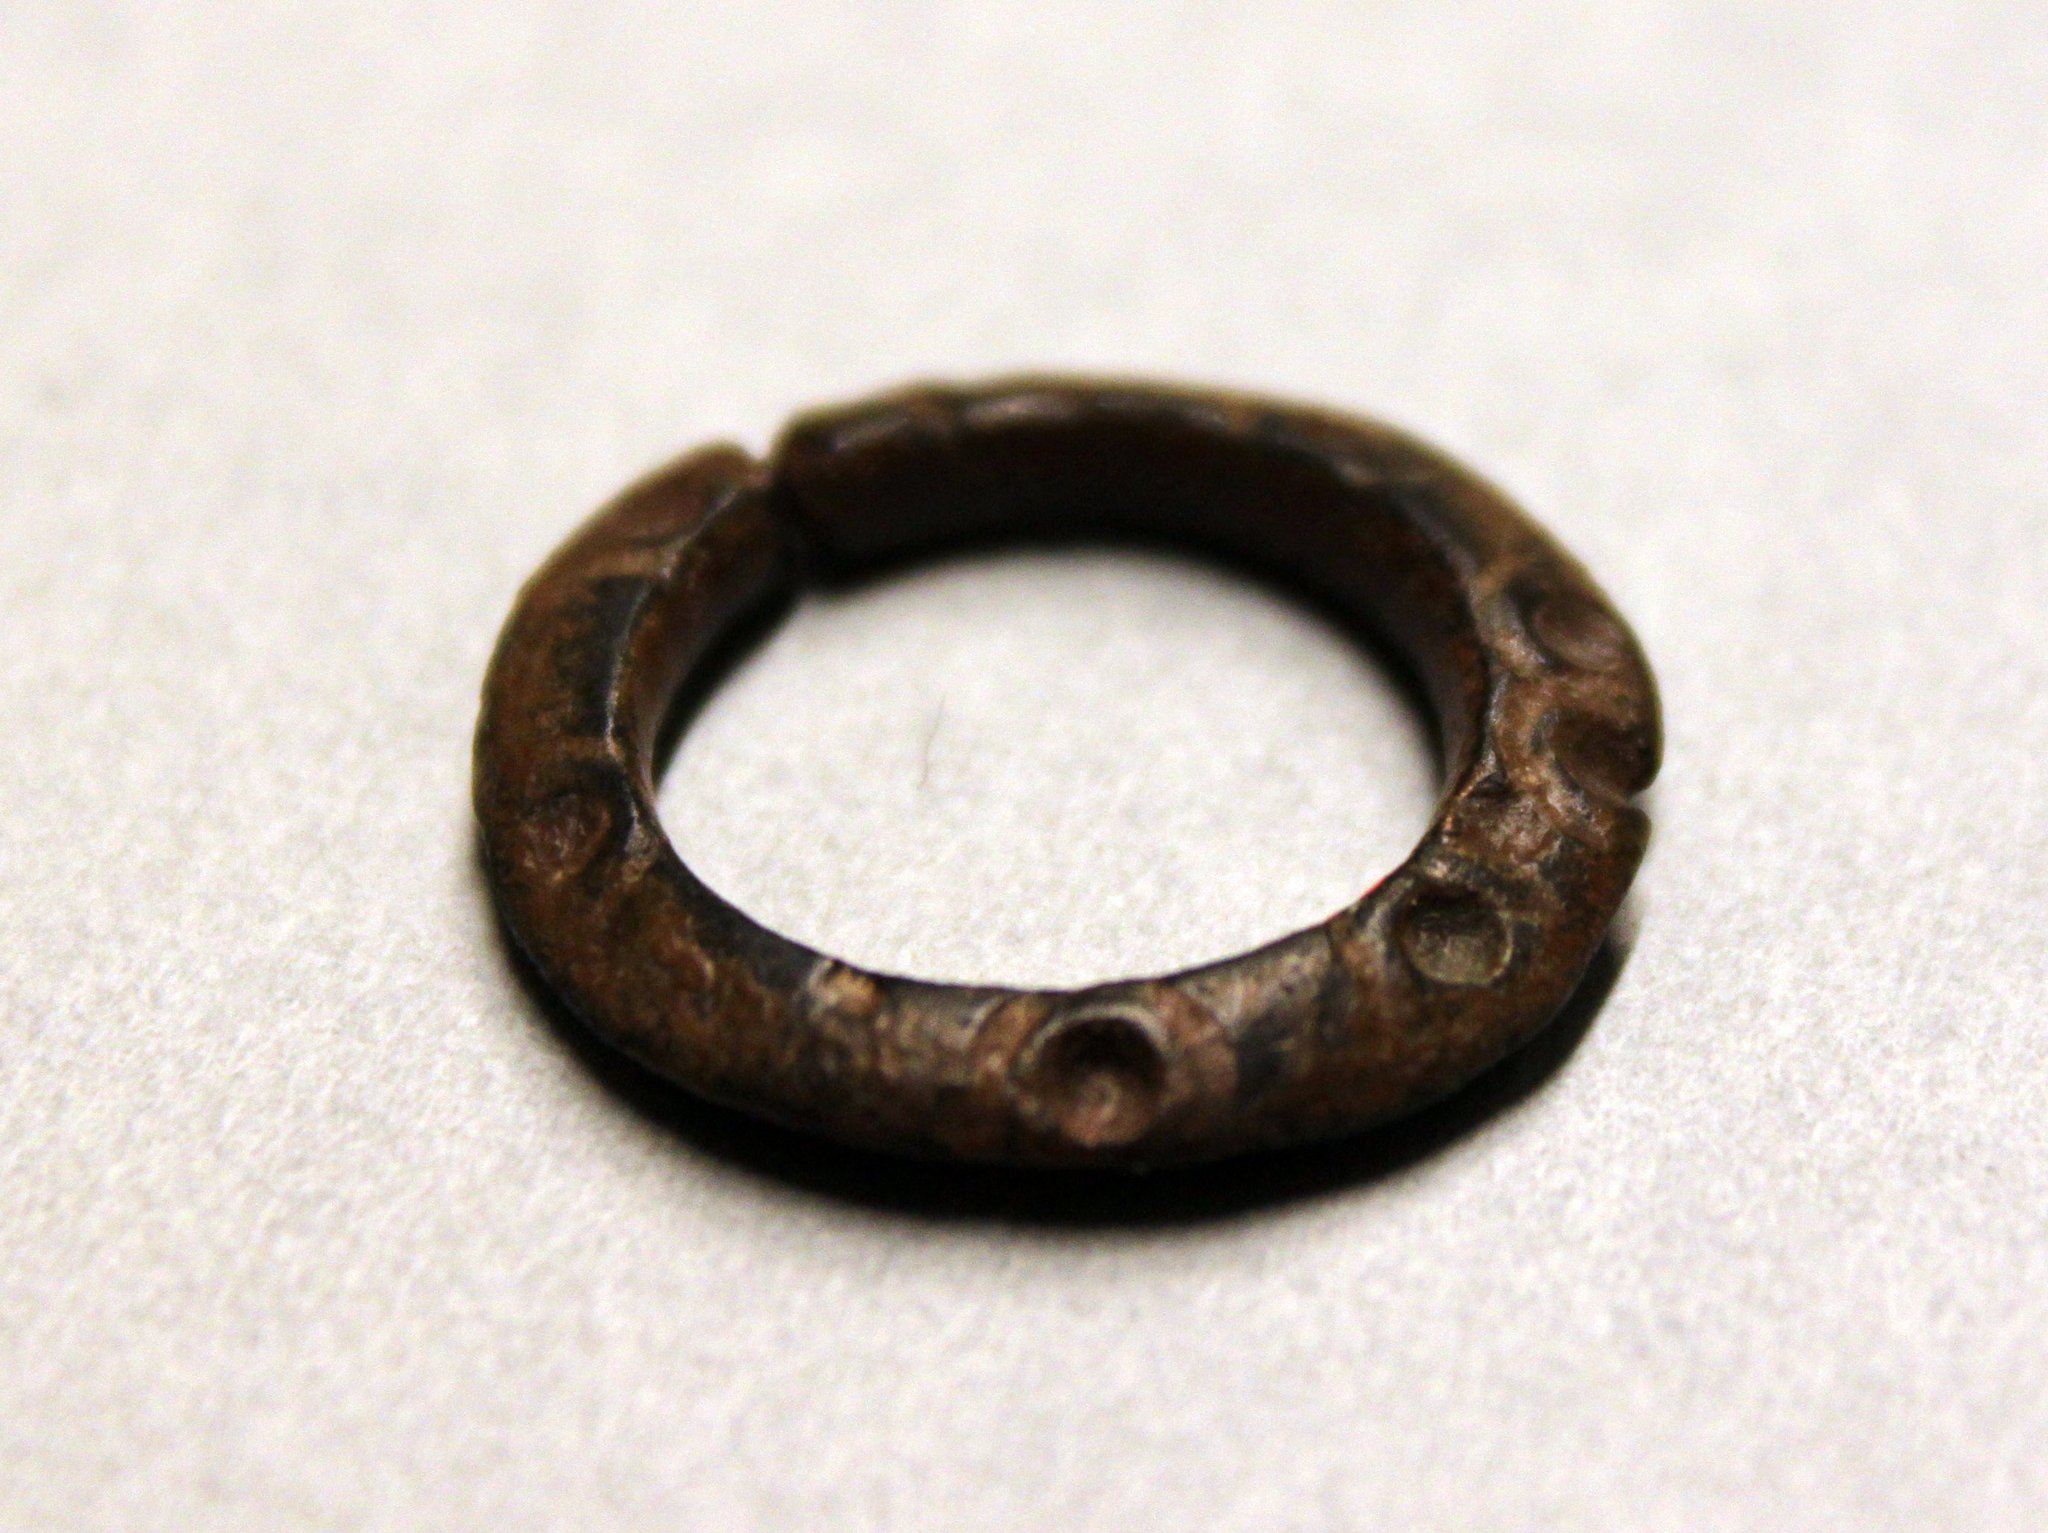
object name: ring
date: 801-1100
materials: bronze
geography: iran